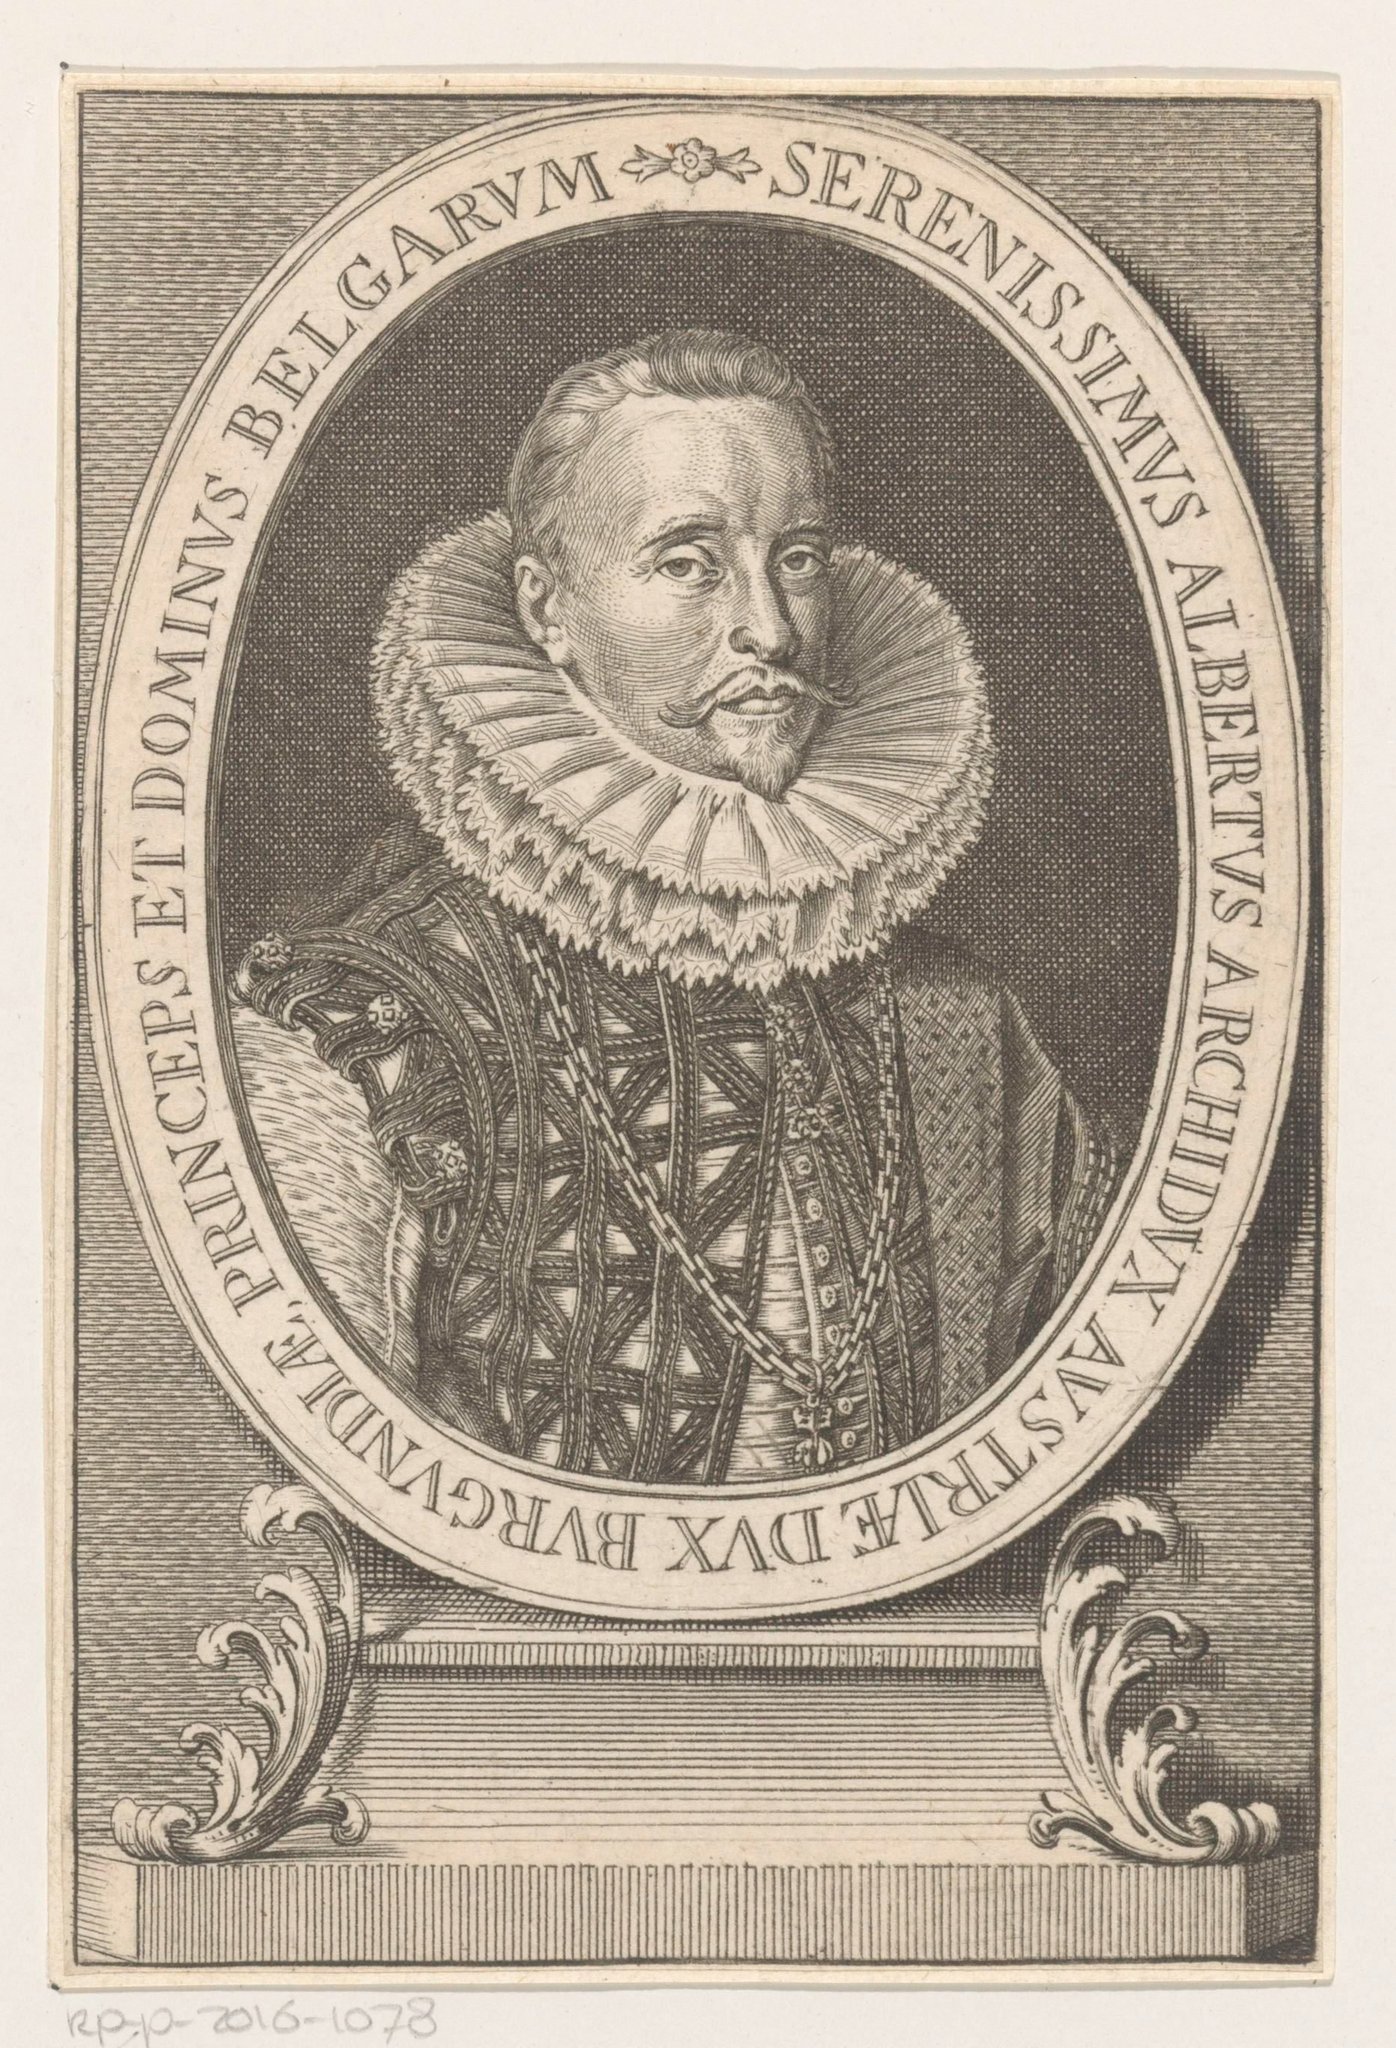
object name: print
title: Portret van Albrecht, aartshertog van Oostenrijk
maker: Anonymous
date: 1600-1699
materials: paper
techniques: engraving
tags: brussels, albrecht aartshertog van oostenrijk, knighthood order of the golden fleece - insignia of a knighthood order, e.g.: badge, chain (with name of order)